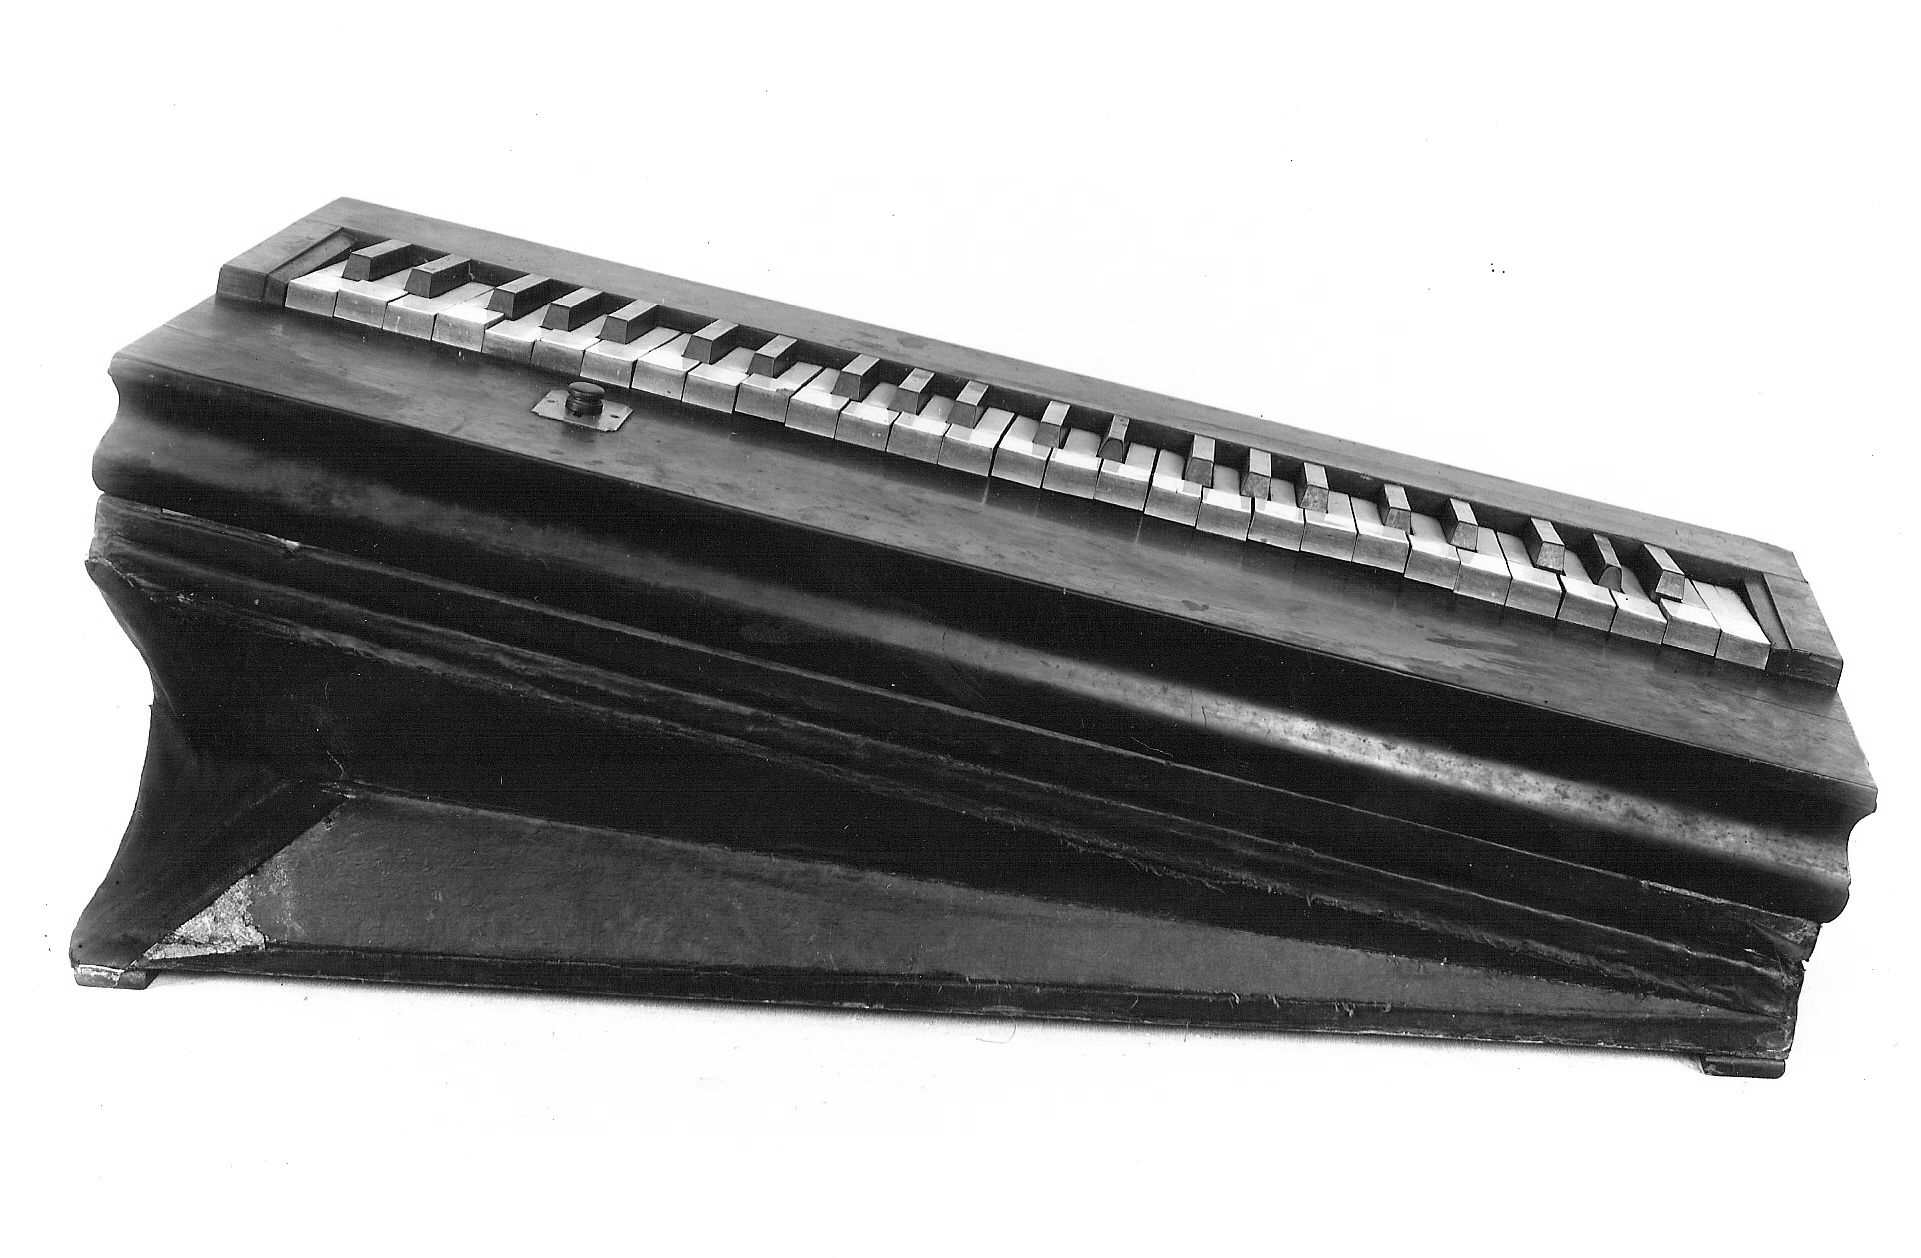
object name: rocking melodeon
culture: american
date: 1826-1850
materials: leather, metal, wood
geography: united states